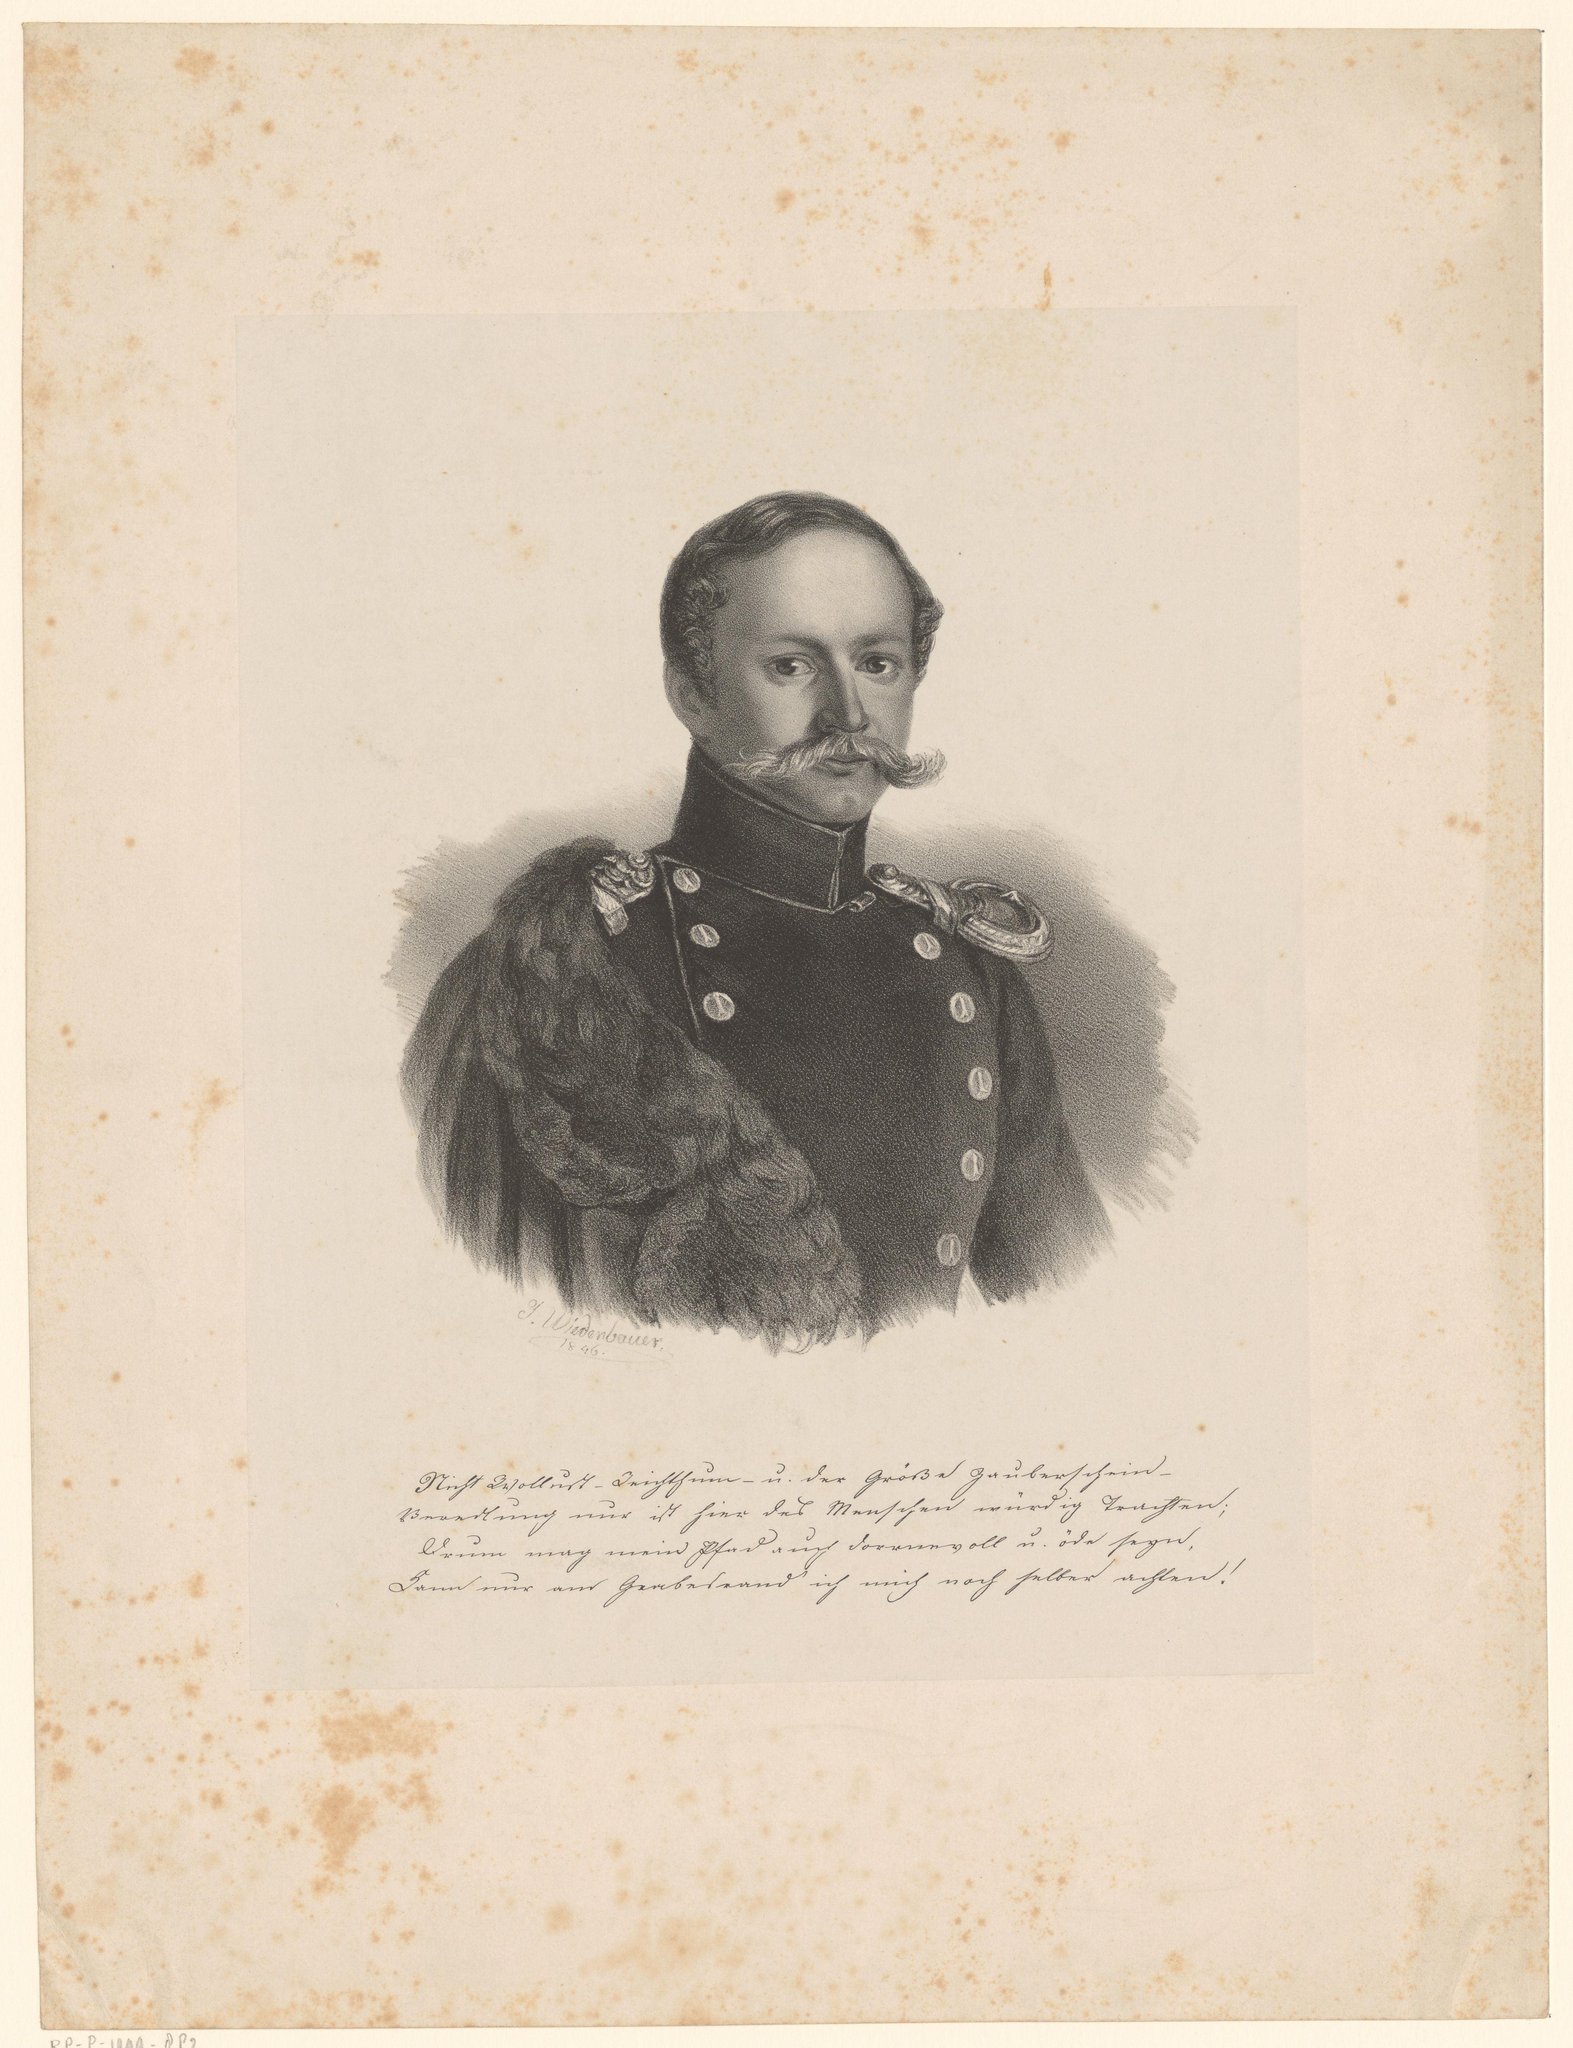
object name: print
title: Portret van een onbekende man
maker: georg widenbauer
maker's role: print maker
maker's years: 1810-1857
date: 1846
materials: paper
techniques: lithograph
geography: germany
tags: moustache, adult man, historical persons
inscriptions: collector's mark: Lugt 2760, collector's mark: Lugt 2228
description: Ten halve lijve, naar rechts. In uniform, met schoudermantel. Met vier regels geschreven Duitse tekst midden onder.